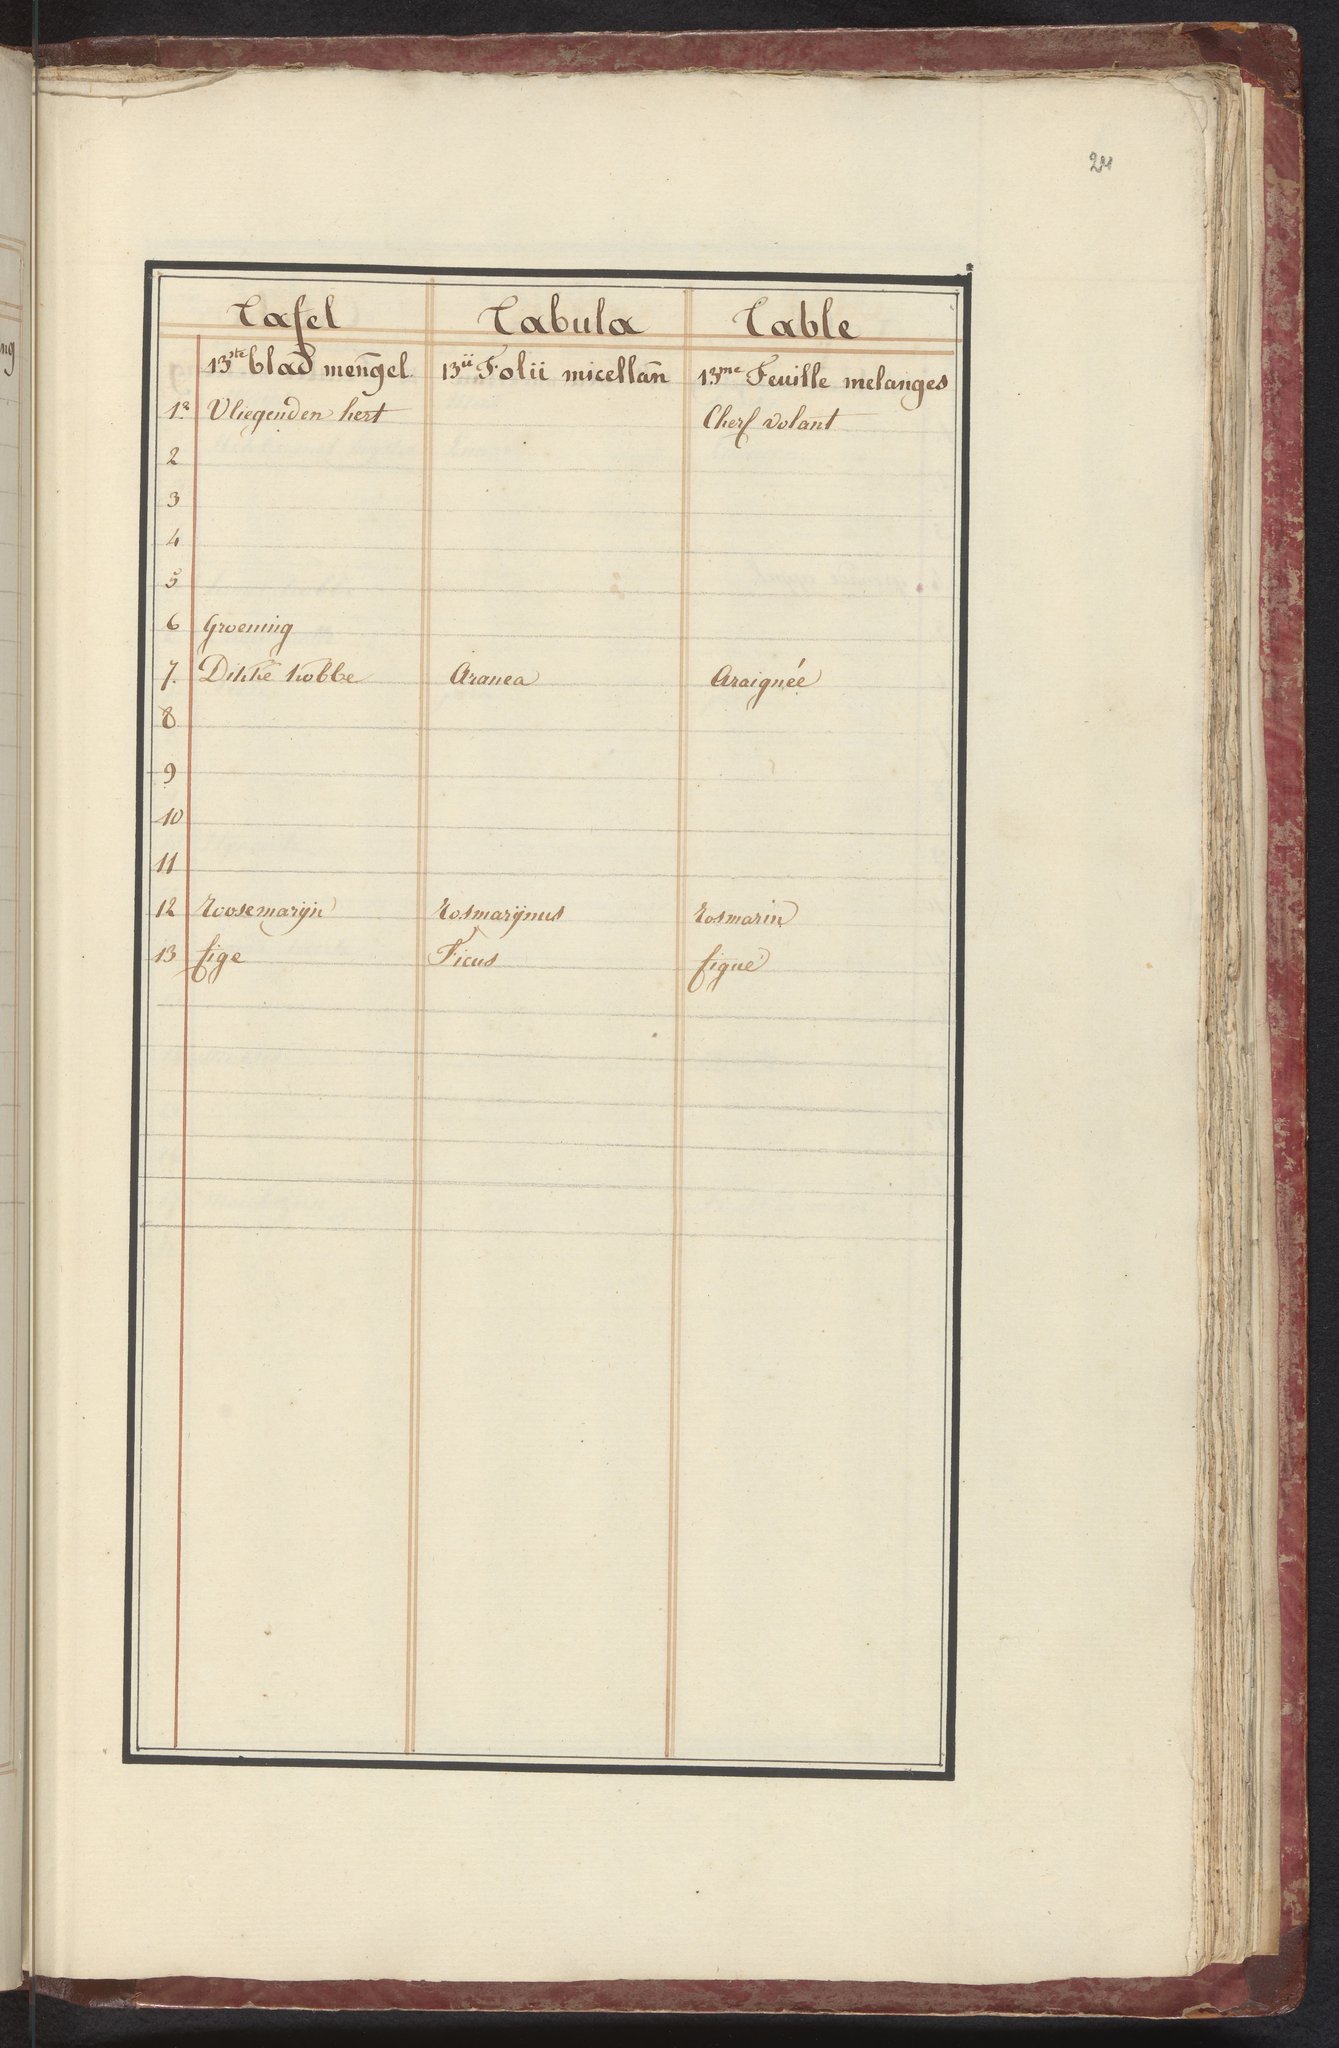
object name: manuscript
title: Tafel 13ste blad mengel. / Tabula 13ii Folii micellan. / Table 13me Feuille melanges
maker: joseph van huerne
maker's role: kunstliefhebber, mecenas, verzamelaar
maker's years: 1752-1844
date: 1809-1814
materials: ink, paper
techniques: handwriting, pen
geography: bruges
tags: handwriting, written text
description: Schema met een lijst in drie kolommen van de dieren en planten afgebeeld in het dertiende ensemble, nummers 1-13. Onderdeel van het zevende album met tekeningen van reptielen, amfibieën en natuurhistorische ensembles. Het zevende van twaalf albums met aquarellen van dieren, vogels en planten bekend rond 1600, gemaakt in opdracht van keizer Rudolf II. Met toelichting in Nederlands, Latijn en Frans.